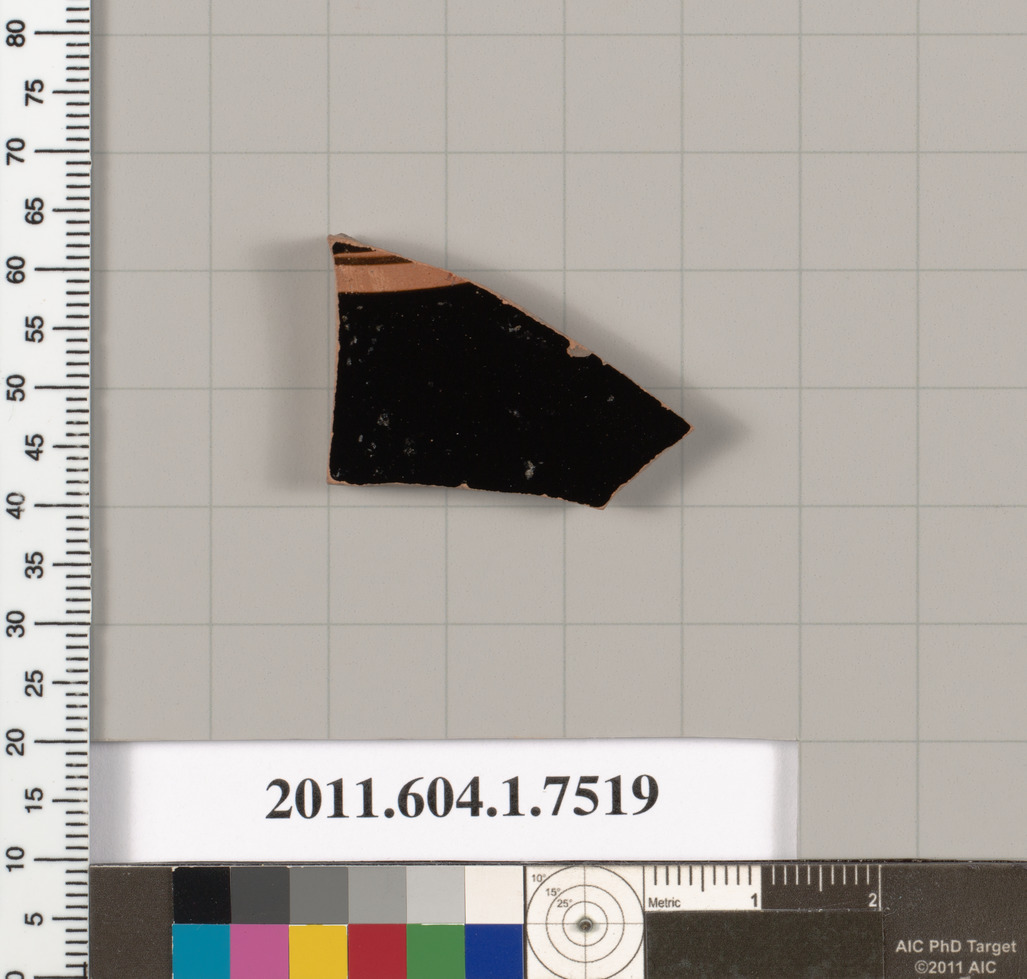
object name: kylix fragment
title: Terracotta fragment of a kylix (drinking cup)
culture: greek, attic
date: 460-450 BCE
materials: terracotta